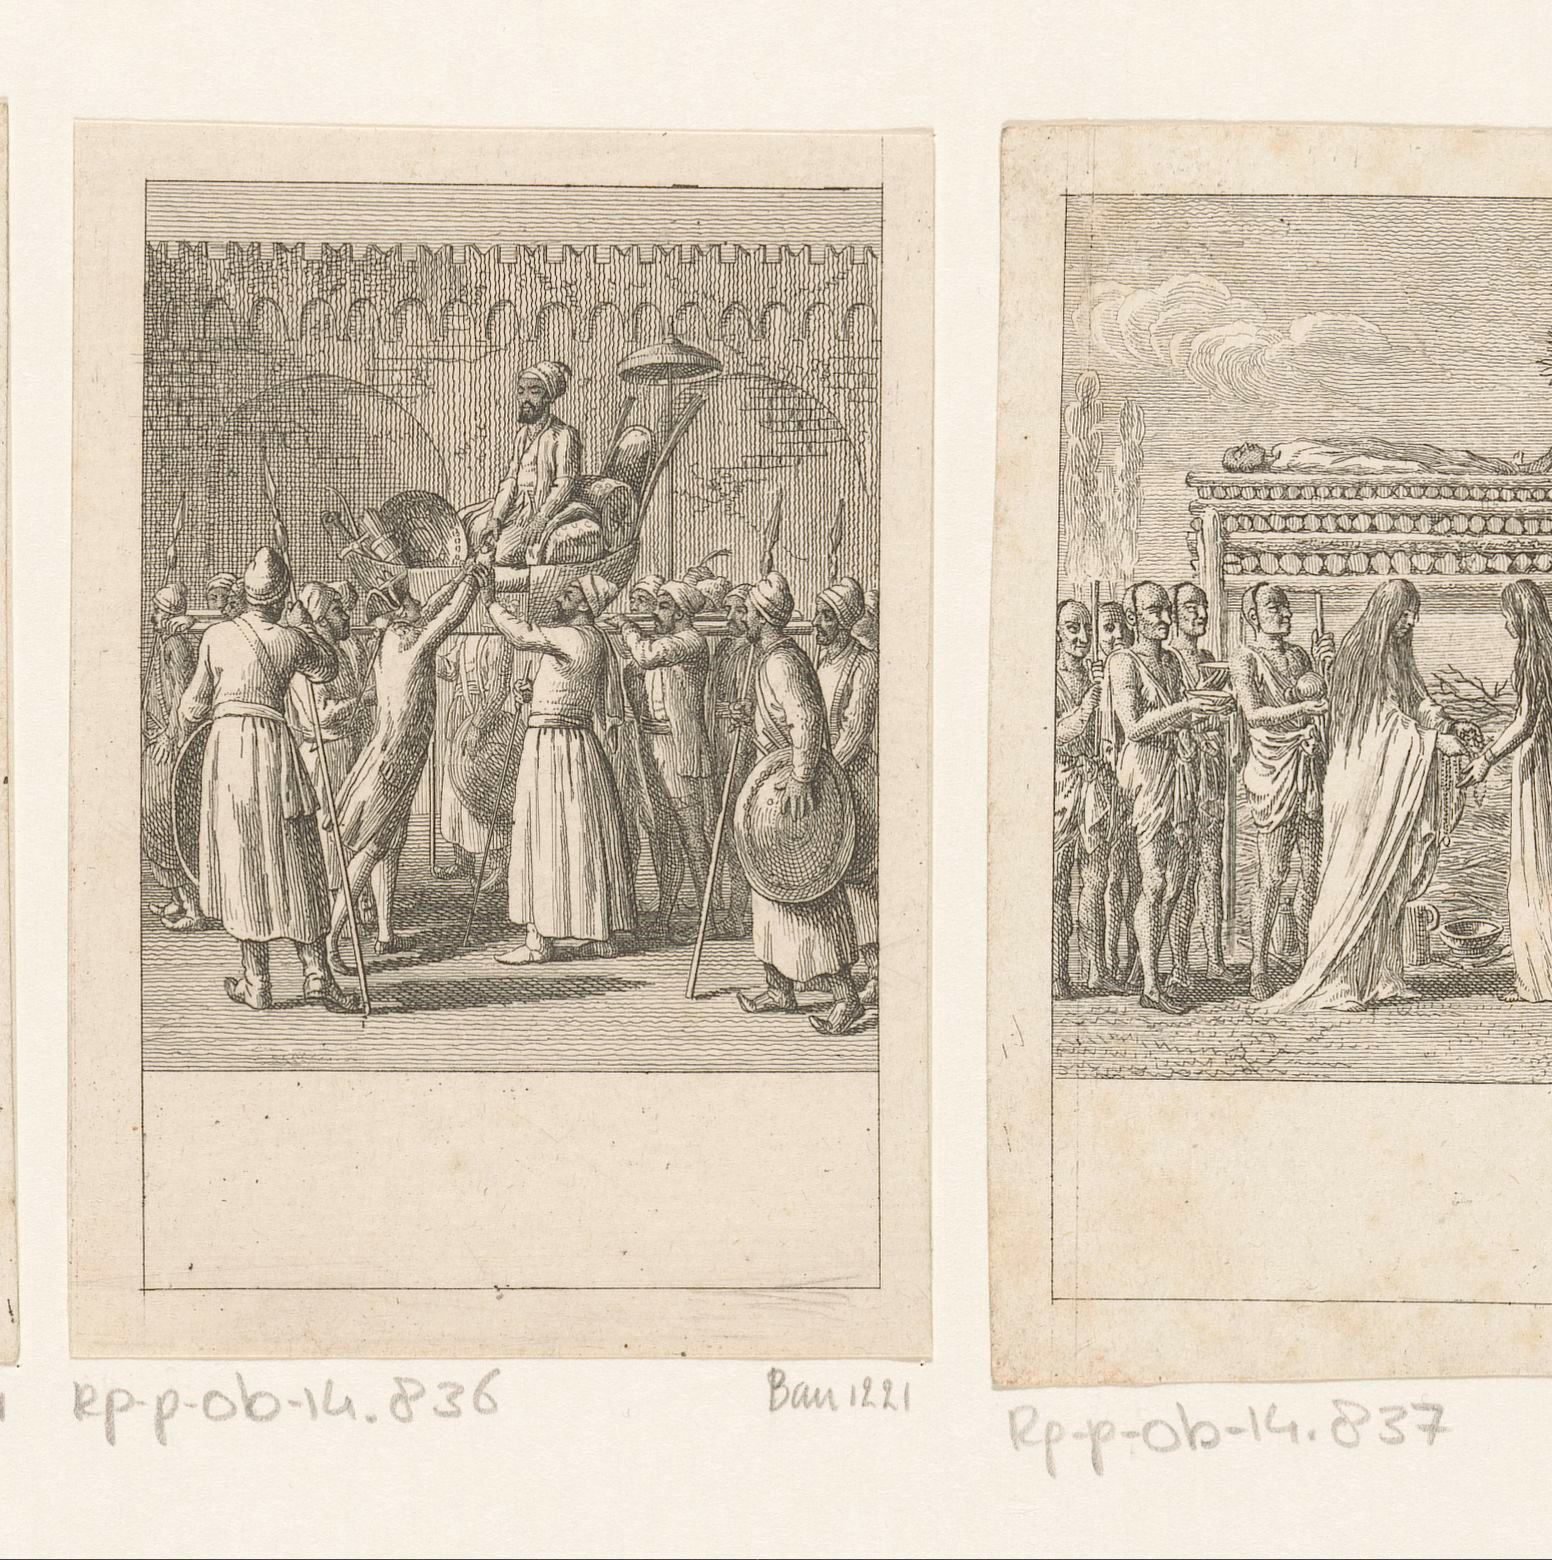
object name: print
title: Mogol laat zich van zijn paleis naar de tuin dragen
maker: daniel nikolaus chodowiecki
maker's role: draughtsman, print maker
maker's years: 1726-1801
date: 1786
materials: paper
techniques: etching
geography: berlin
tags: (carrying a person in a) sedan-chair, asiatic races and peoples: indians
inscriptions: collector's mark: Lugt 2228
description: Latere staat gebruikt voor: Sprengel, Matthias Christian. Historisch-genealogischer Calender, oder, Jahrbuch der merkwürdigsten neuen Welt-Begebenheiten für 1786. Leipzig: Zur Messe bey Haude und Spener von Berlin, s.a.